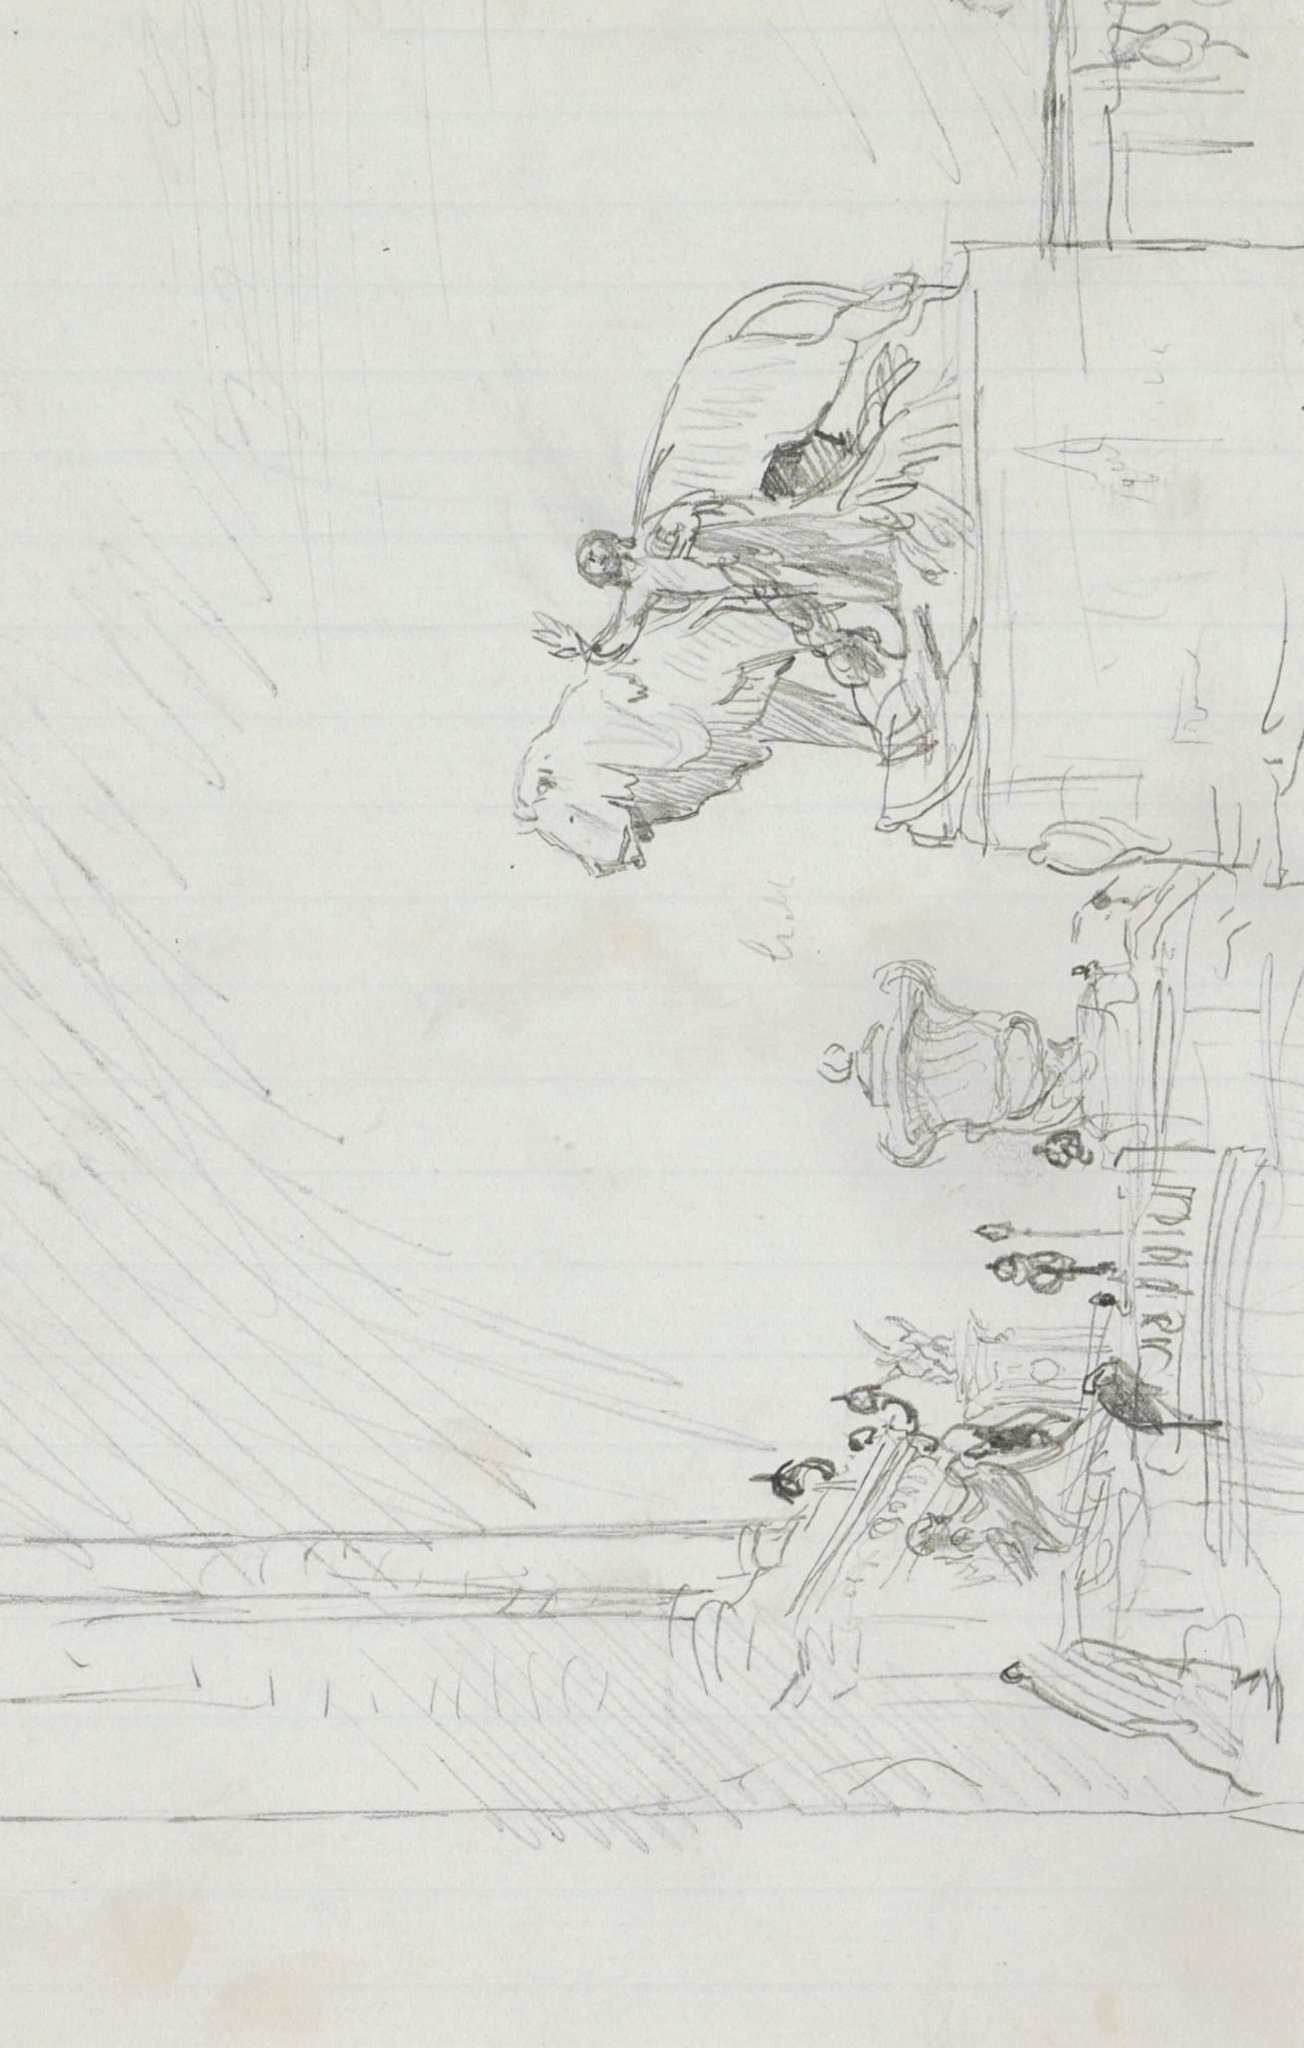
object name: sketchbook leaf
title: Beeld van een leeuw bij een gebouw met een zuilengalerij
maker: marius bauer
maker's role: draughtsman, print maker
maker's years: 1867-1932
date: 1877-1932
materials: pencil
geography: paris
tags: column, pillar ~ architecture, monument, statue, beasts of prey, predatory animals: lion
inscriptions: kleurnotitie, handgeschreven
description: Pagina 81 uit een schetsboek met 68 bladen.